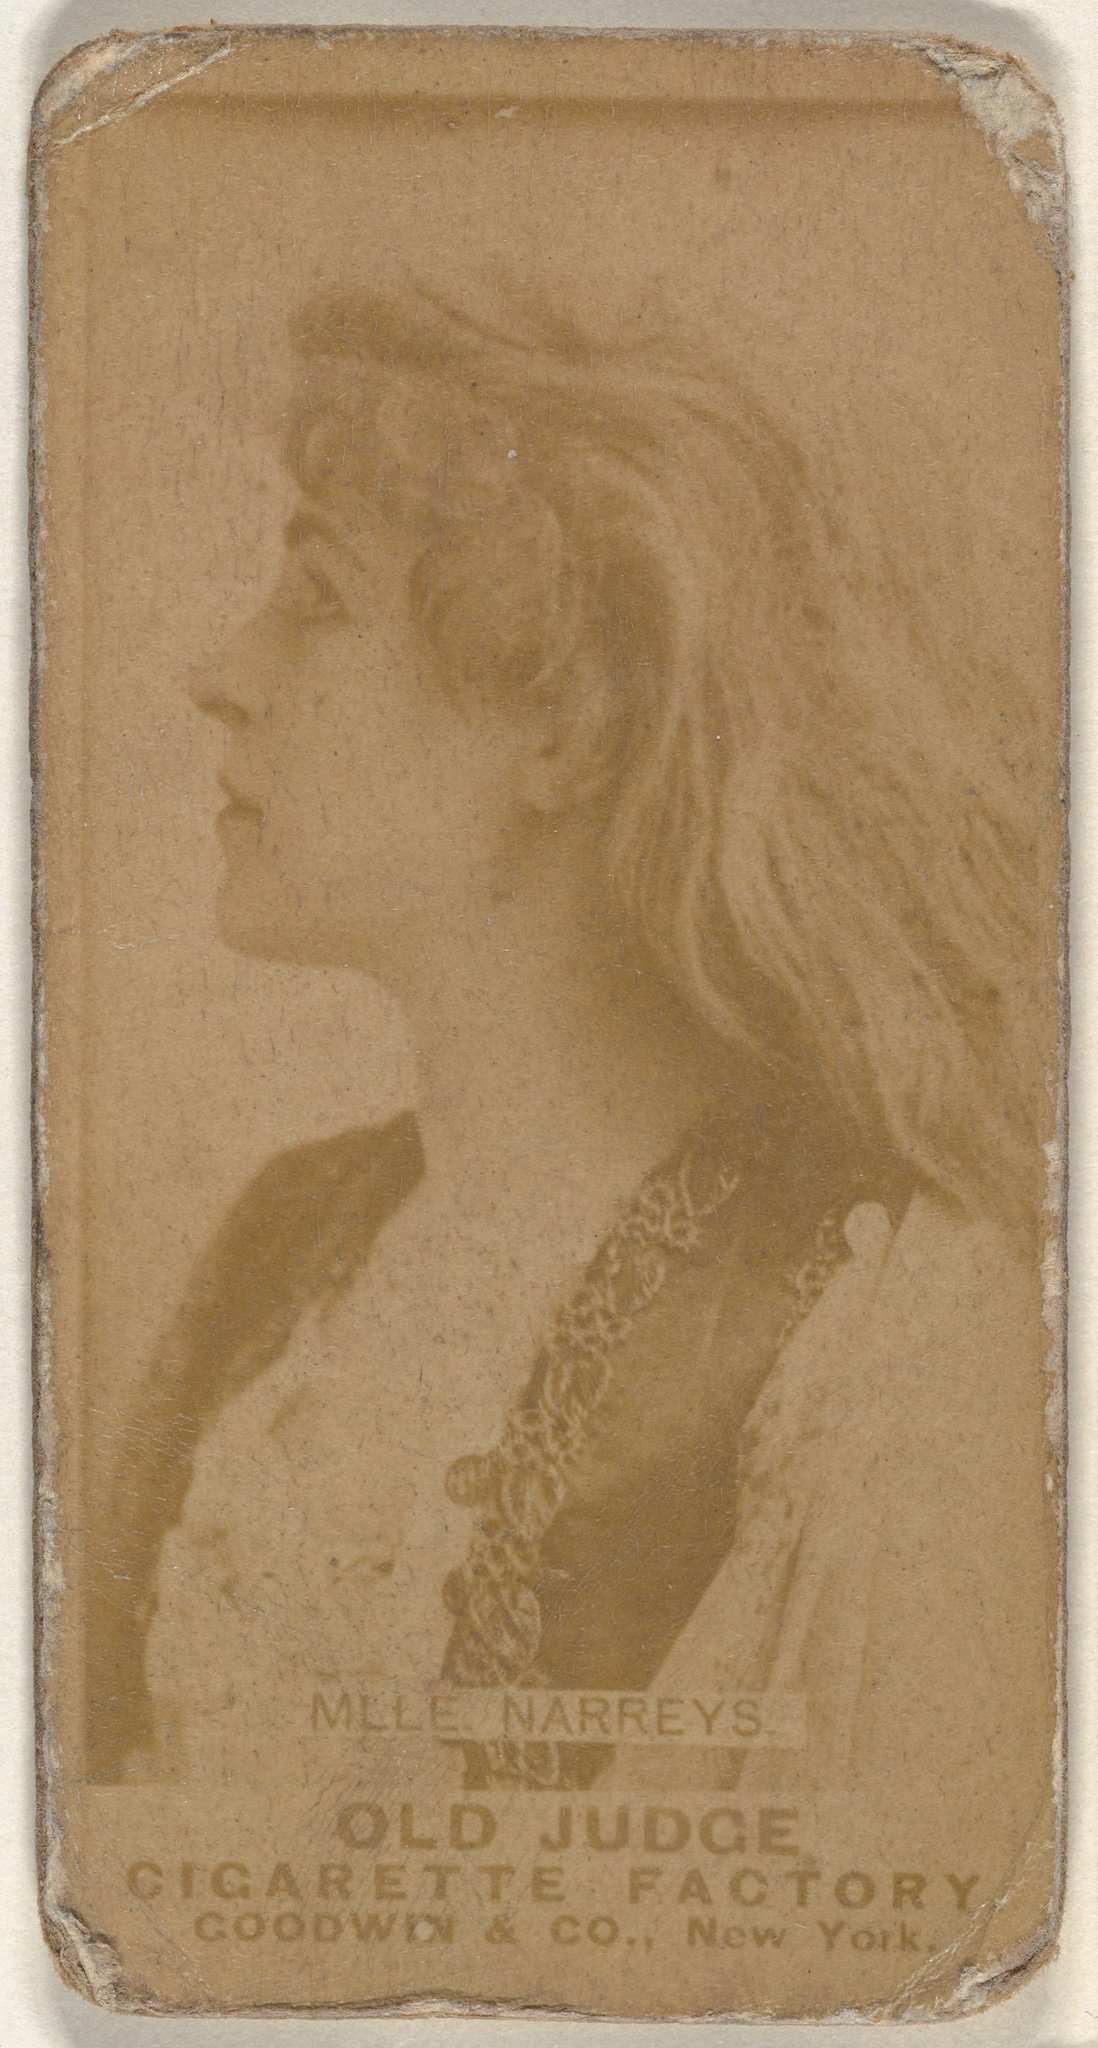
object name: photograph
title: Mlle. Narreys, from the Actors and Actresses series (N171) for Old Judge Cigarettes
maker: goodwin & company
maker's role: publisher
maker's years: 1850-1950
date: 1886-1890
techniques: albumen silver print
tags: portraits,women,actresses